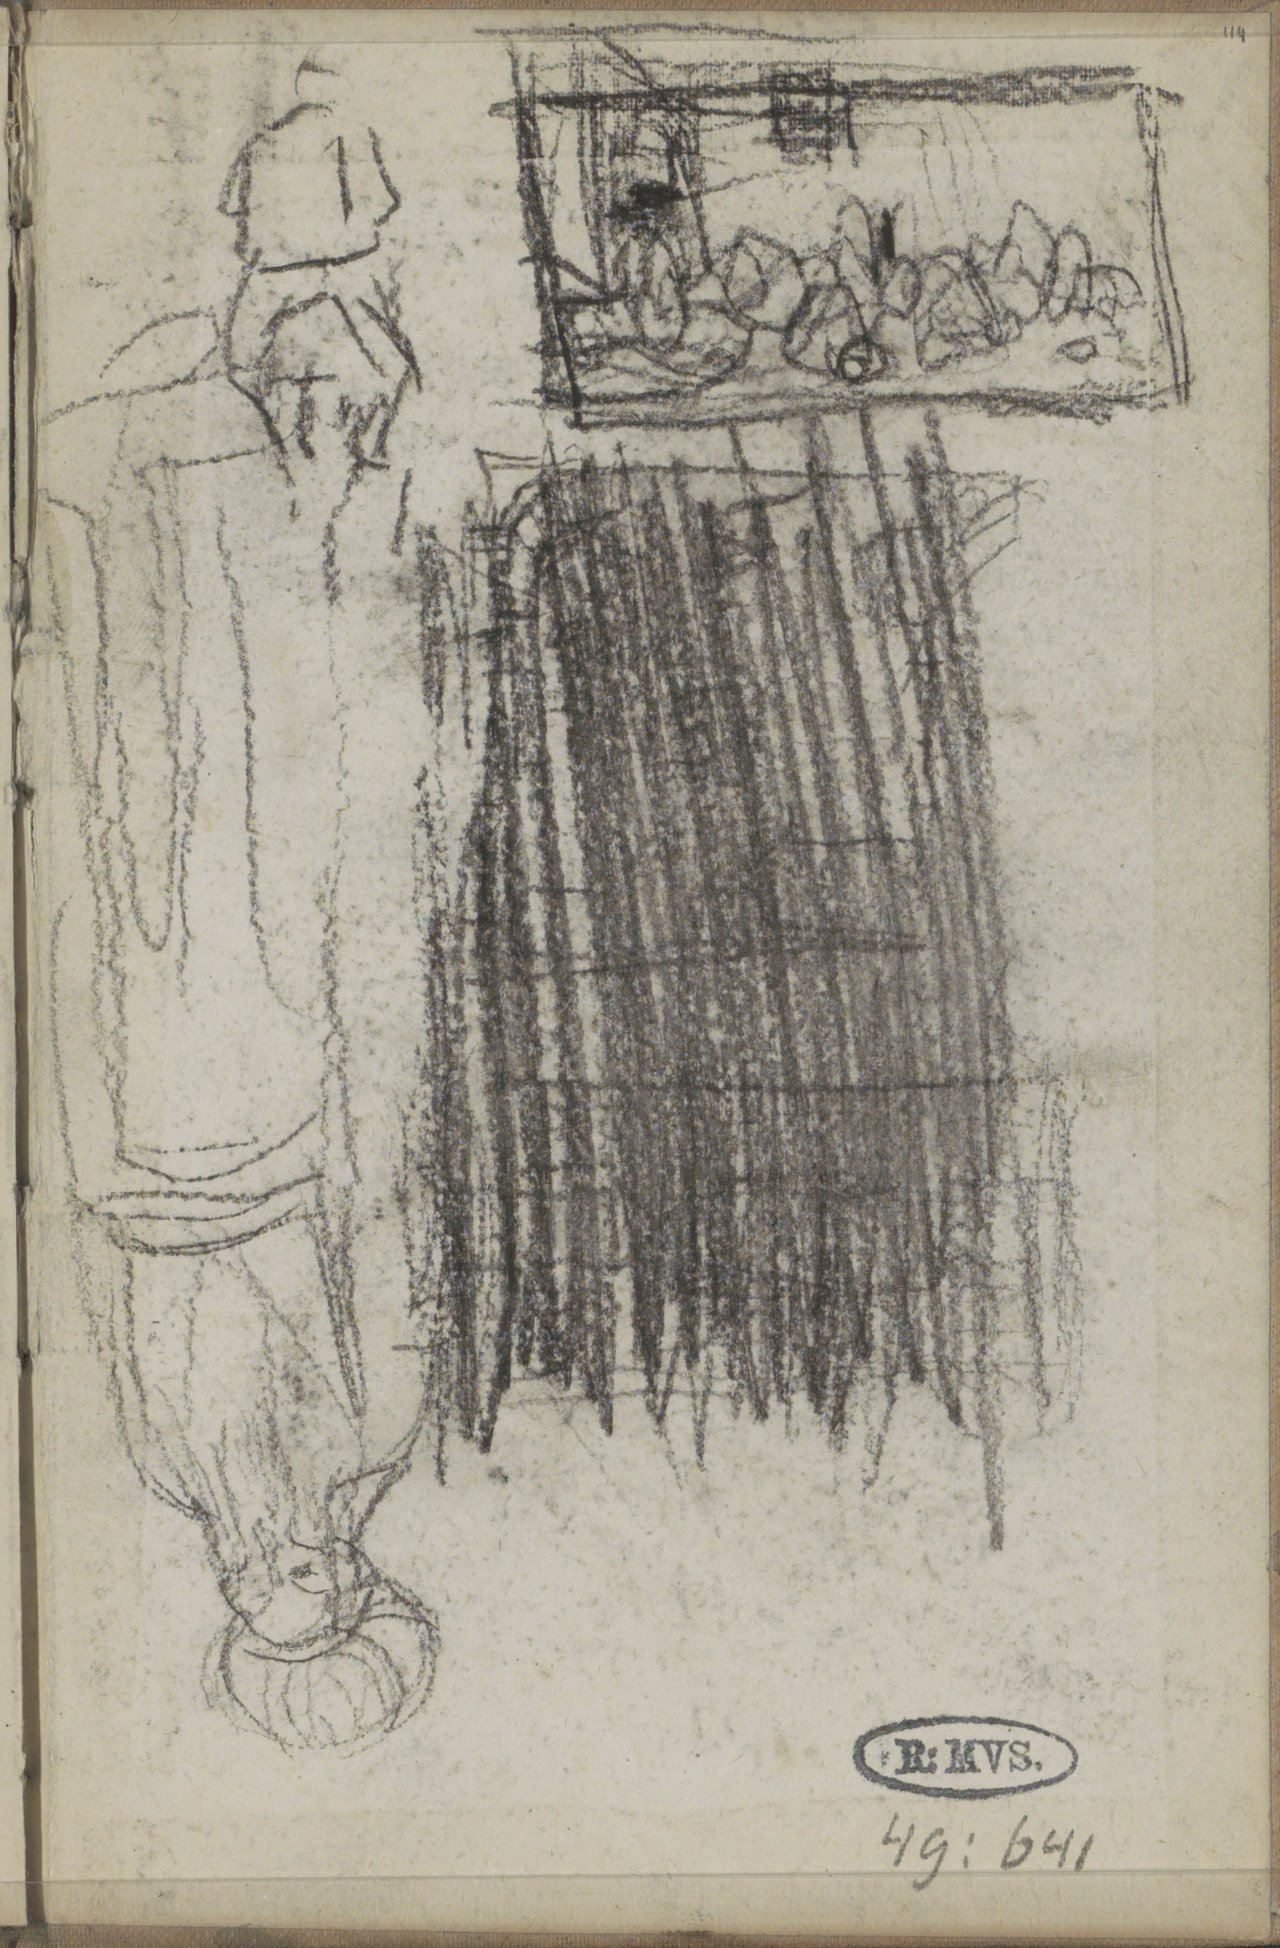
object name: sketchbook leaf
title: Studieblad, onder andere met een ruiter en staande man in in oosterse kleding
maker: marius bauer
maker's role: draughtsman, print maker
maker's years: 1867-1932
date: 1888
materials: chalk, paper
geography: istanbul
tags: riding a horse, ass, or mule; rider, horseman, asiatic races and peoples, standing figure, sitting figure, adult man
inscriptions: collector's mark: Lugt 2228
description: Tevens een studie van zittende figuren in een interieur. Pagina 114 uit een schetsboek met 56 bladen.